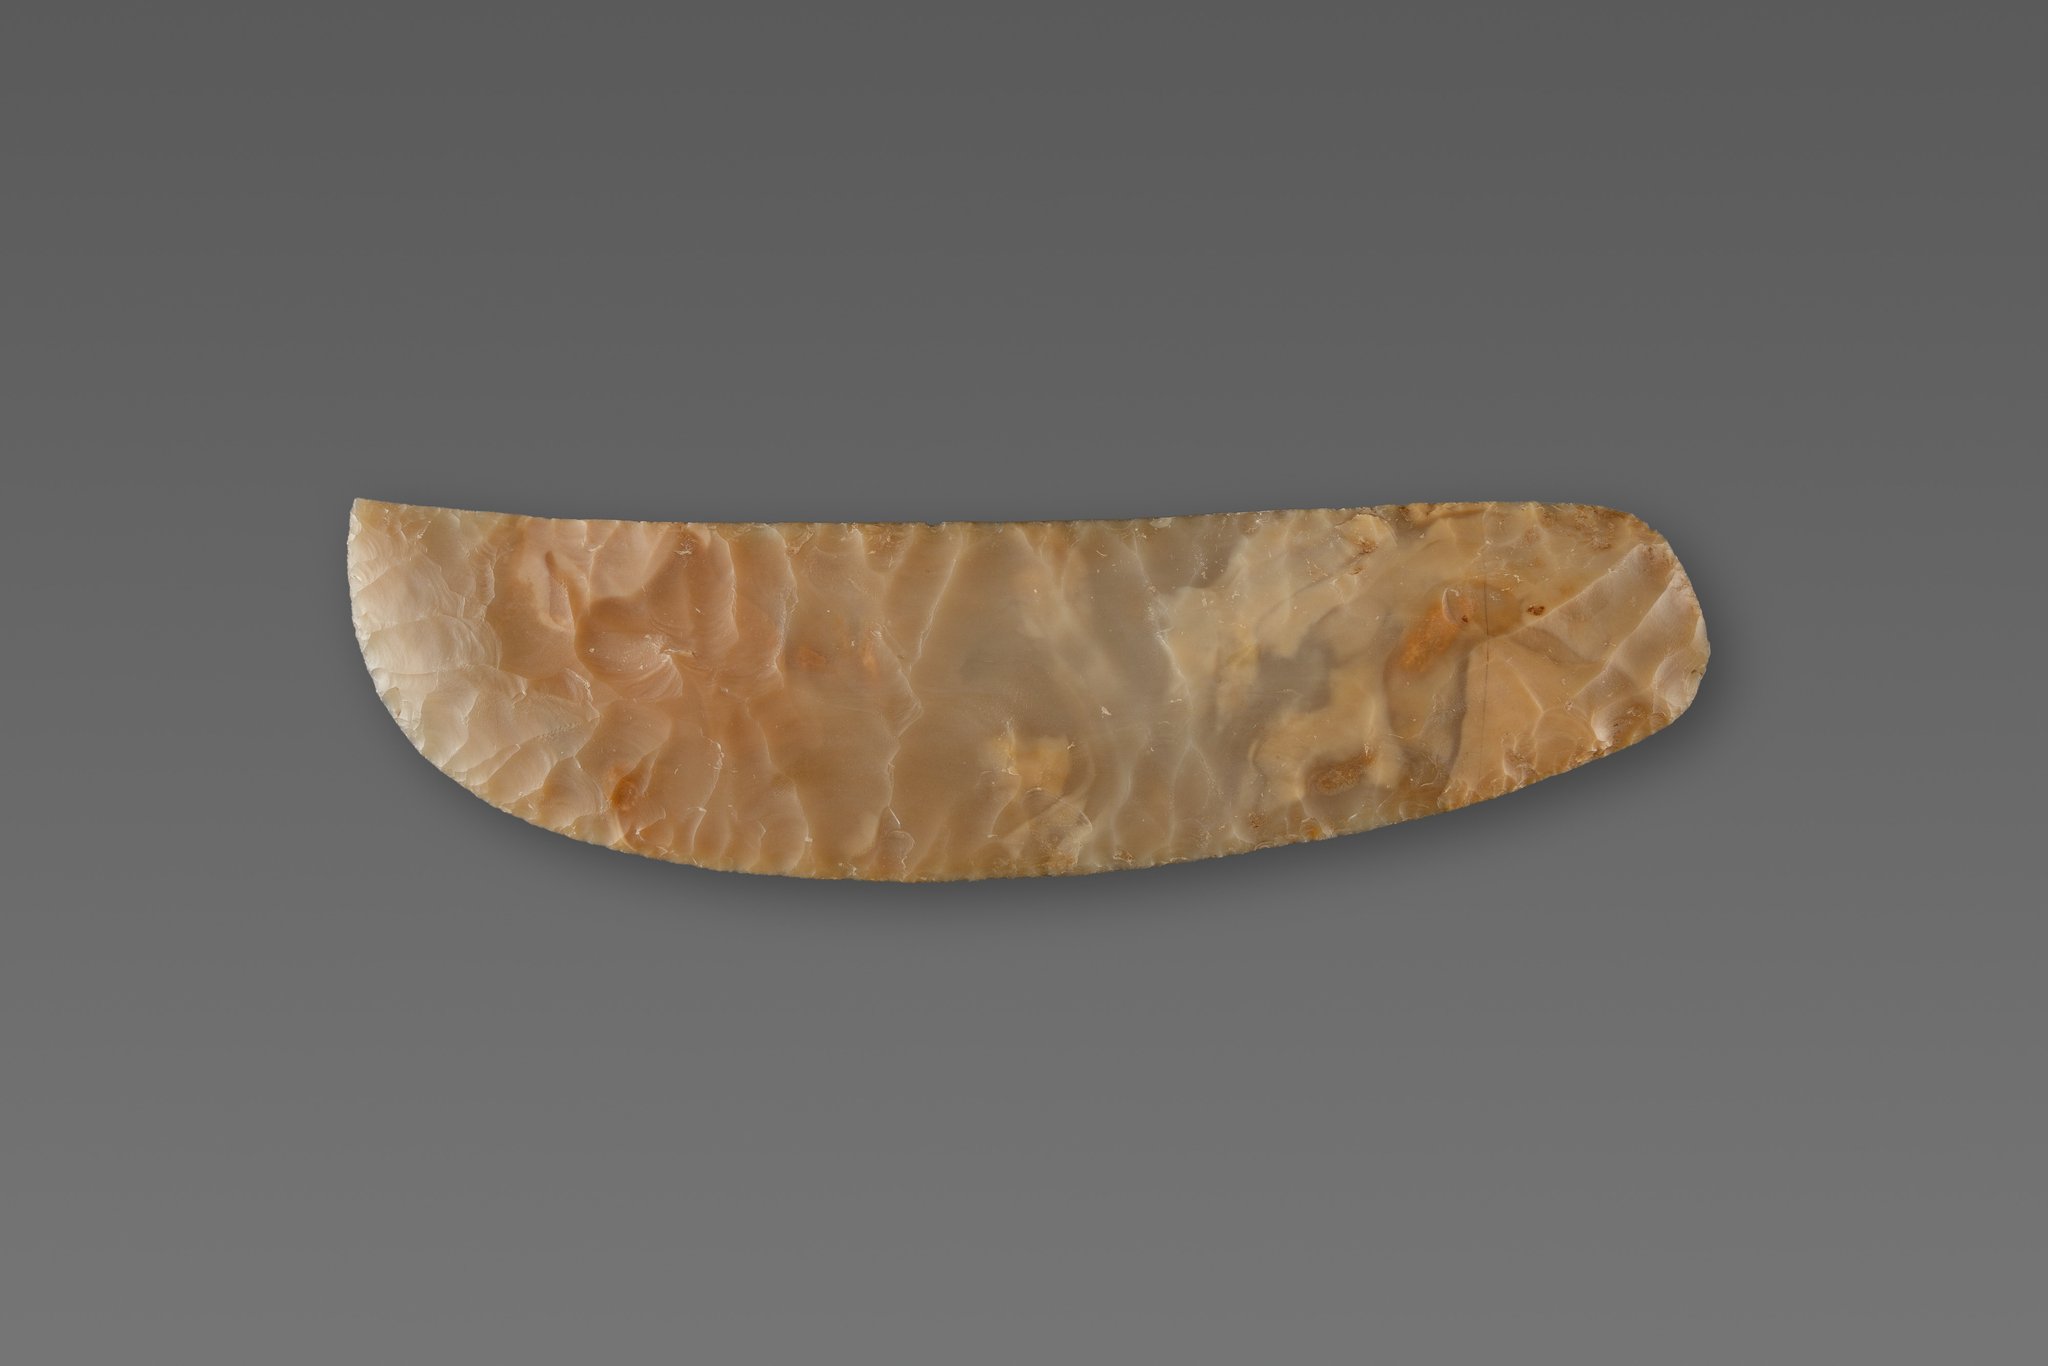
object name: knife, bifacial knife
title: Bifacial Knife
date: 3650-3100 BCE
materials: stone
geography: egypt